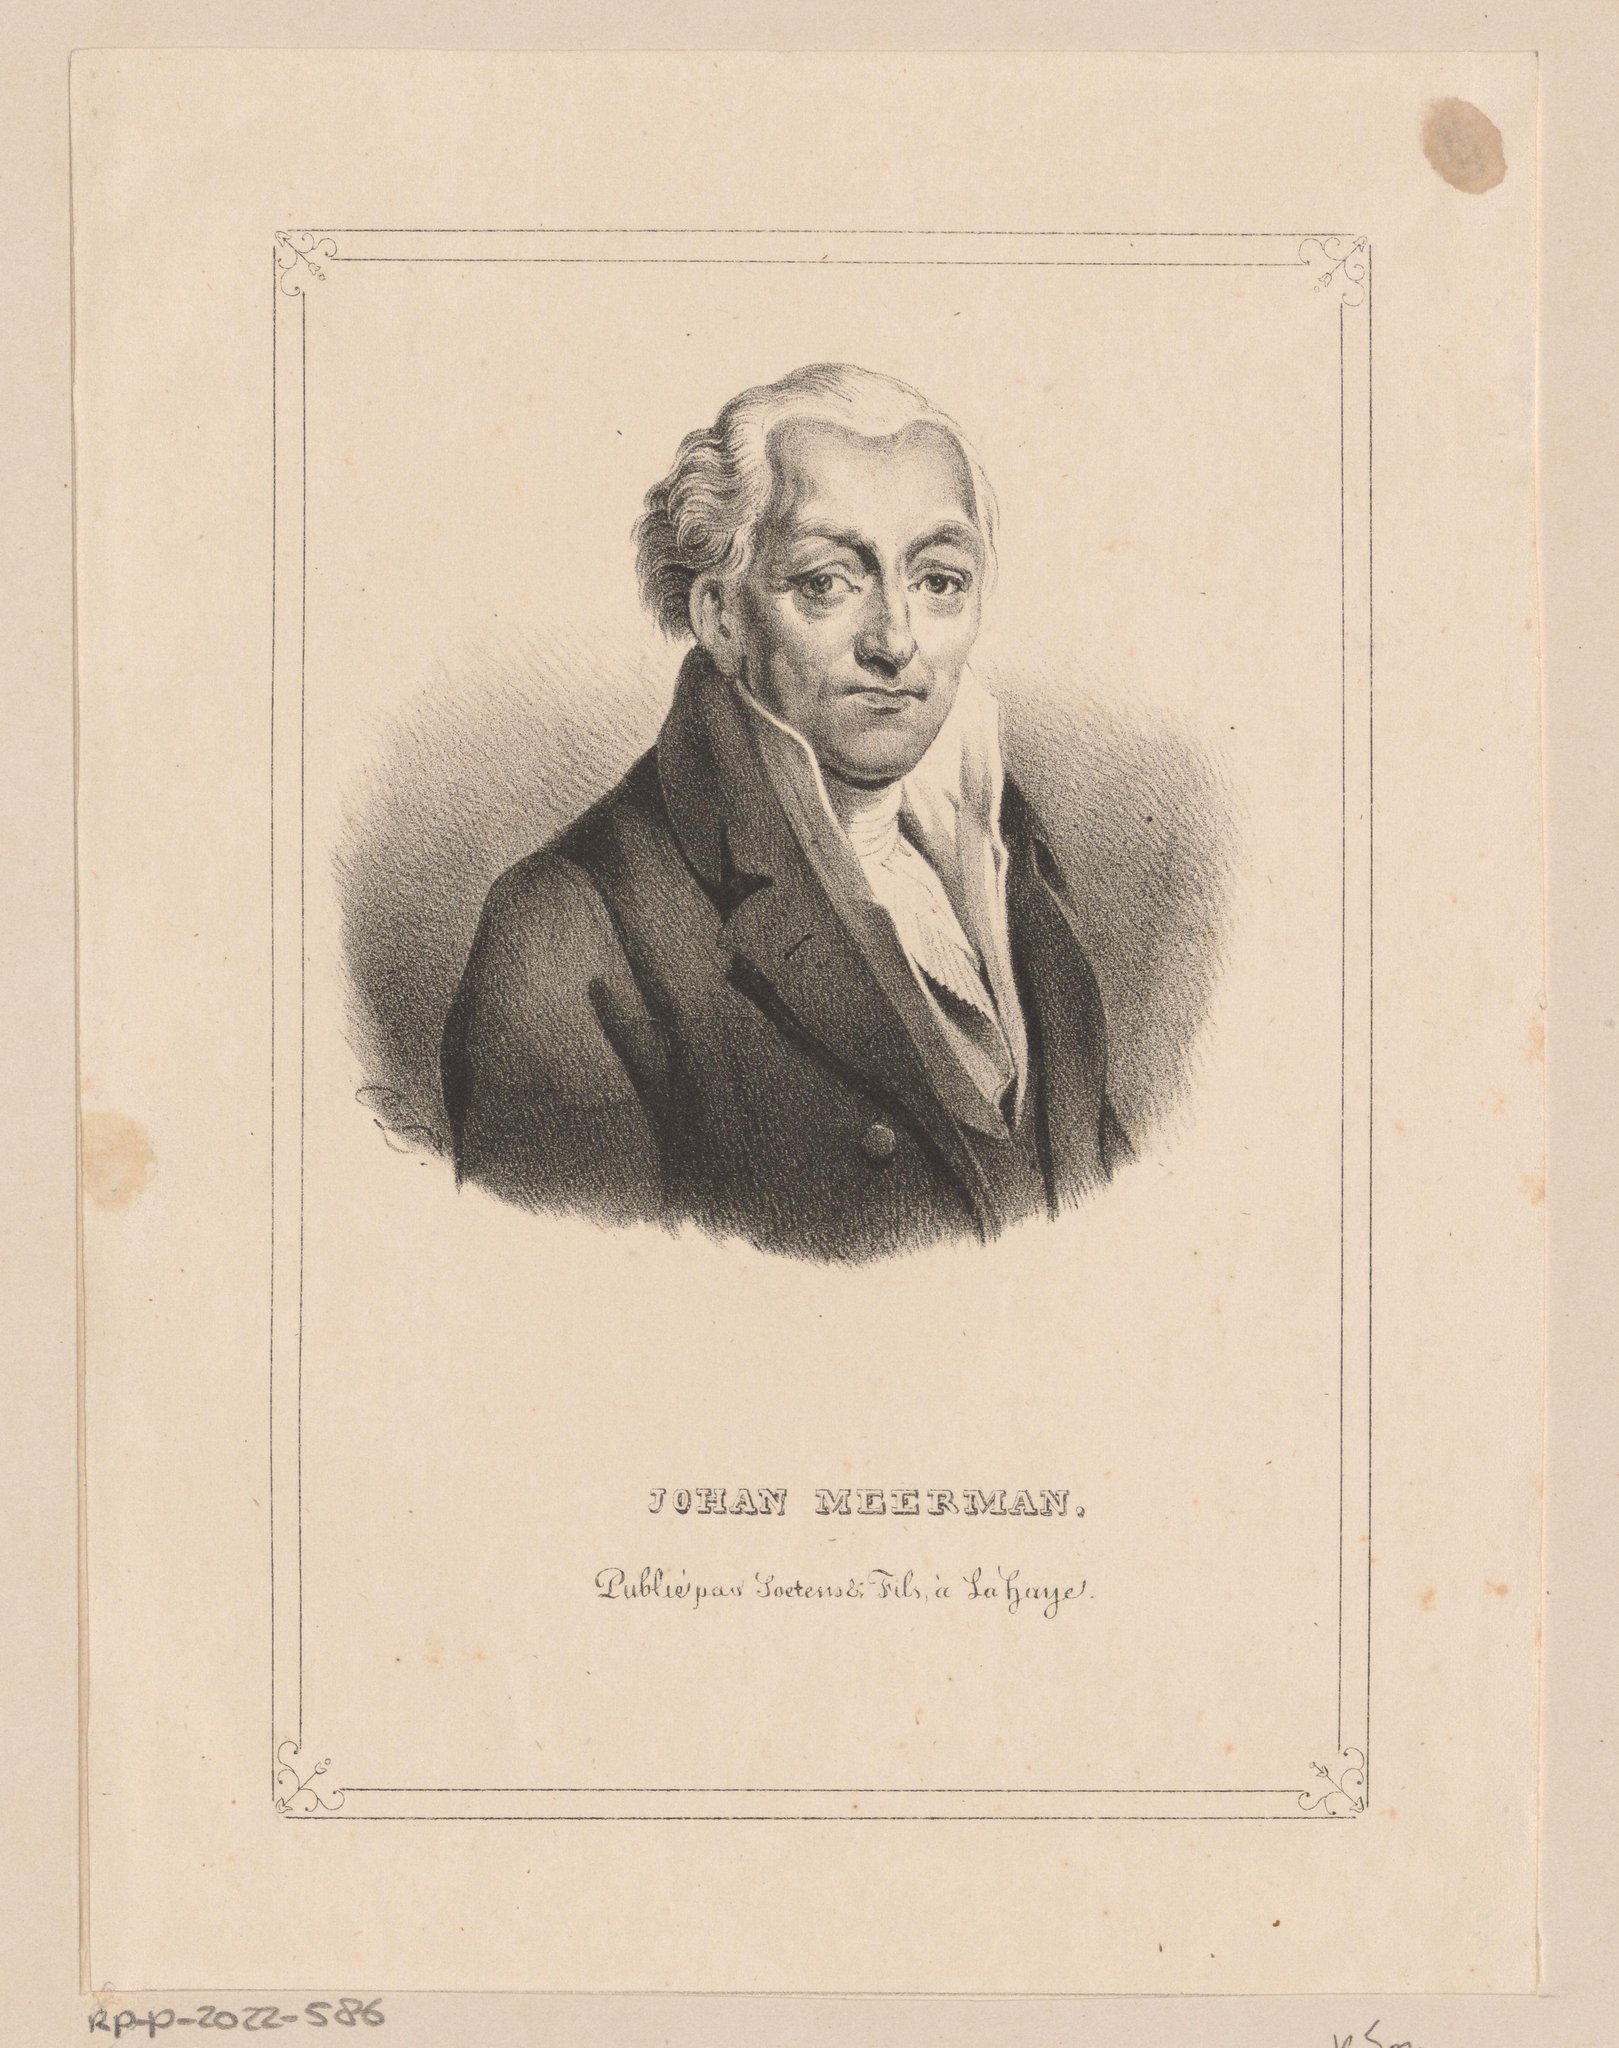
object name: print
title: Portret van Johan Meerman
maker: carel christiaan antony last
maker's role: print maker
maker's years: 1808-1876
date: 1837-1840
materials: paper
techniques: lithograph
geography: the hague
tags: the hague, historical persons